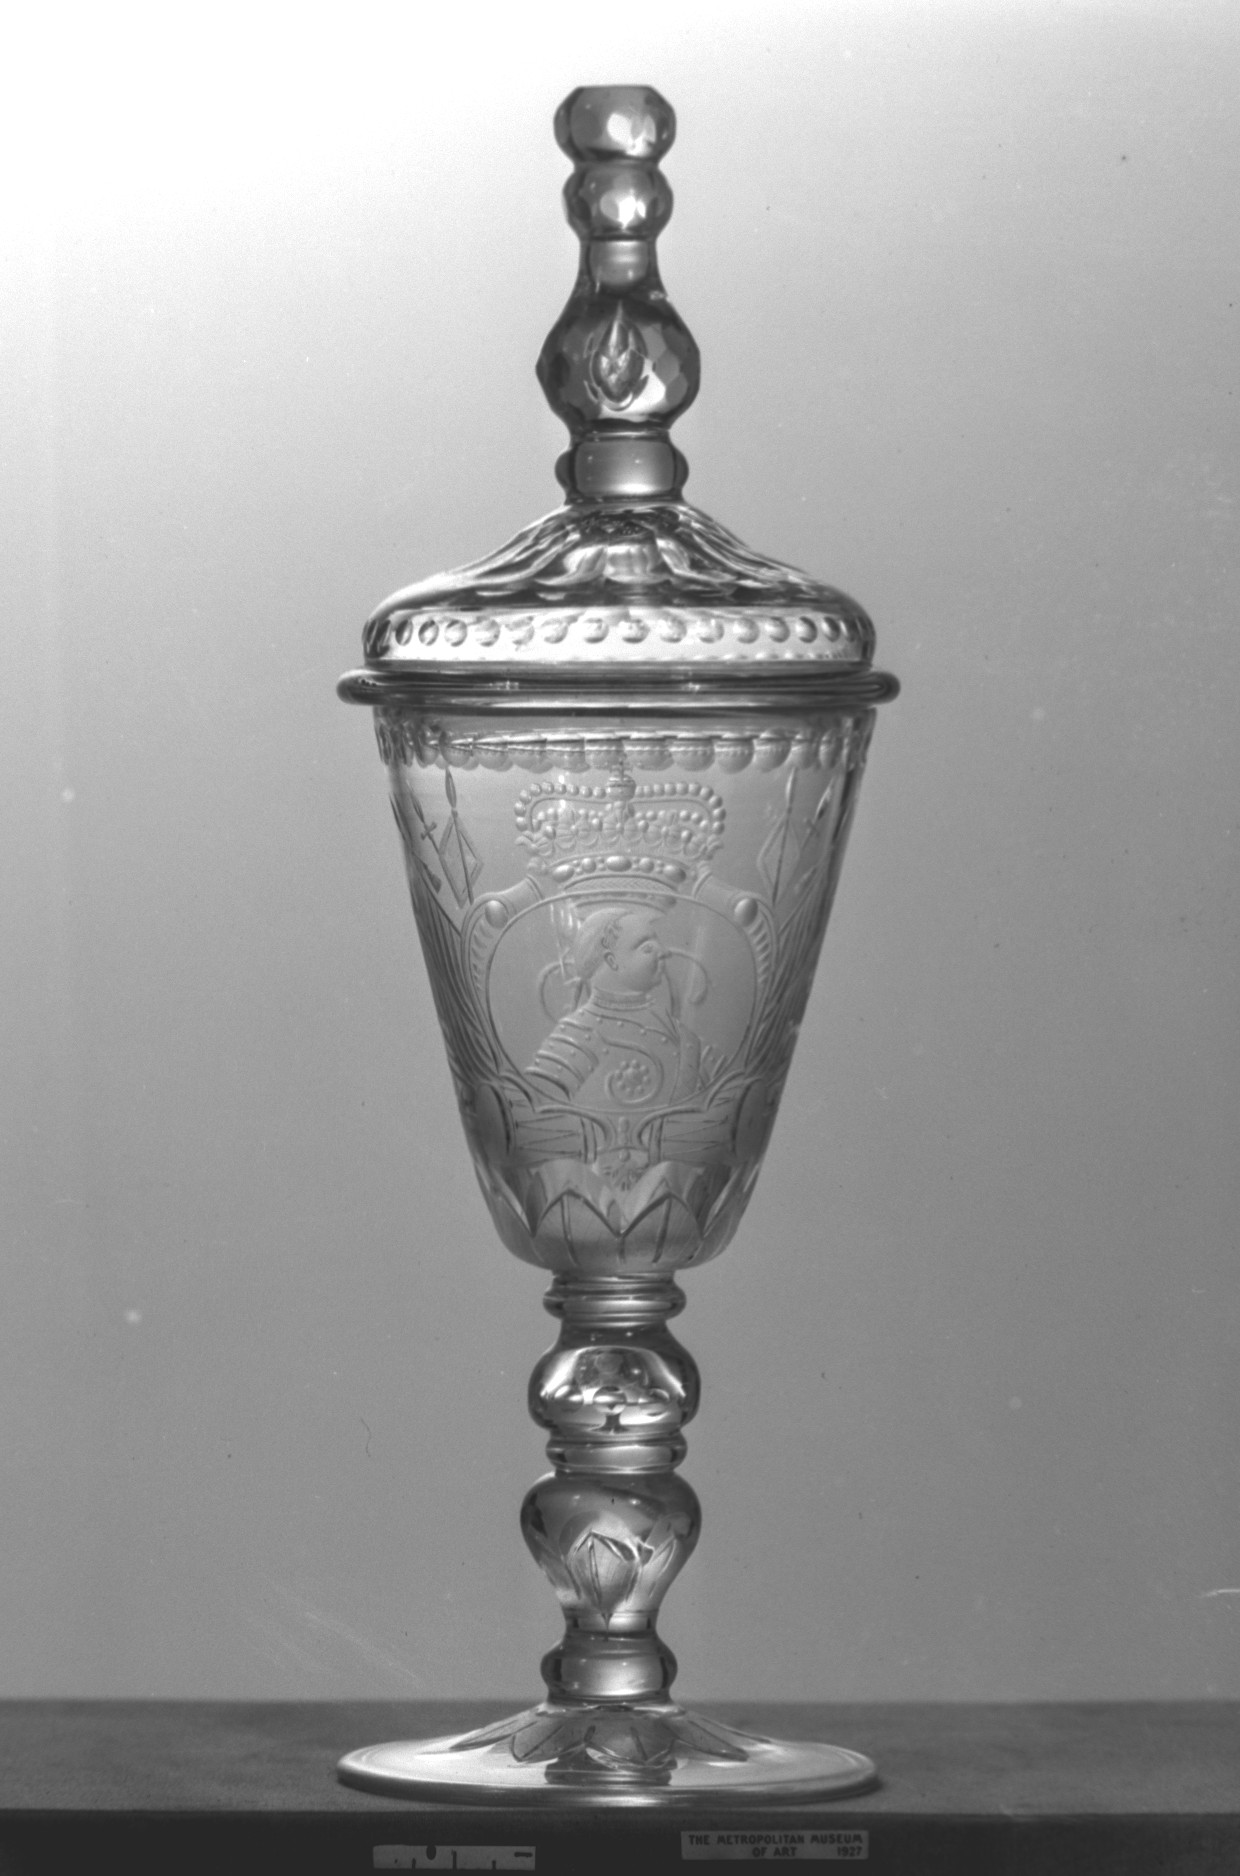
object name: standing cup with cover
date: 1735-1740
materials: glass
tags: men,profiles